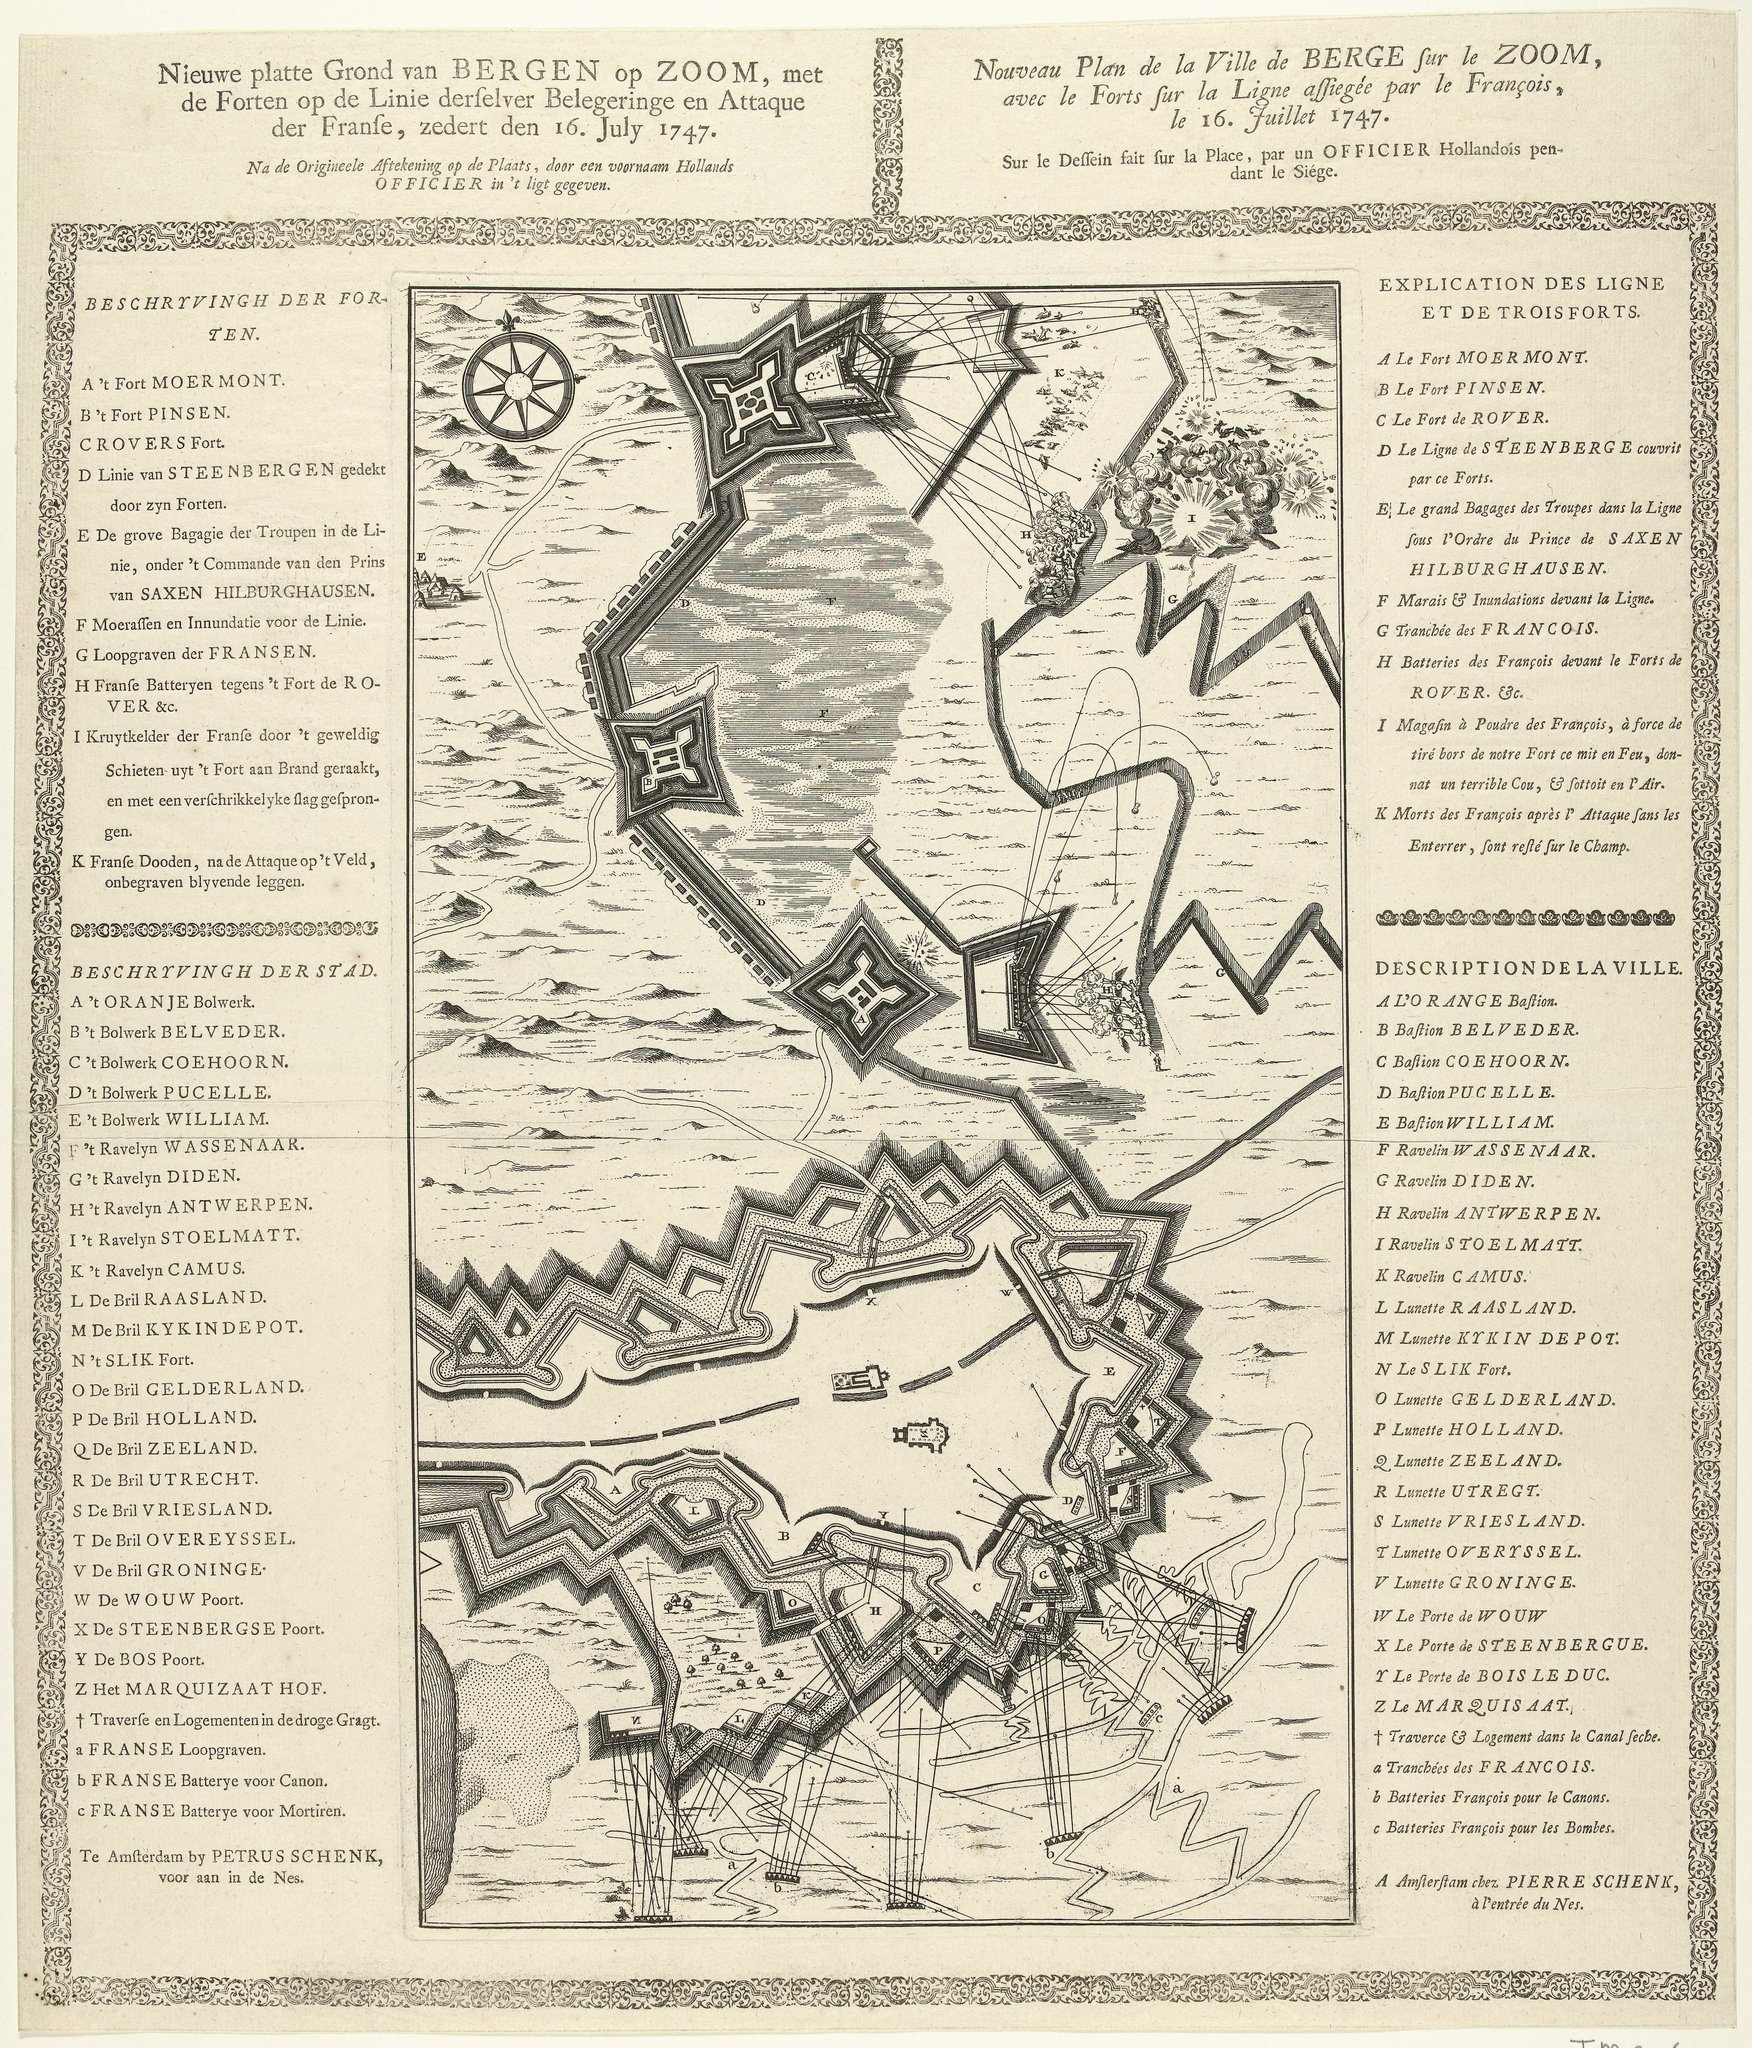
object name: print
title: Nieuwe platte Grond van Bergen op Zoom, met de Forten op de Linie derselver Belegeringe en Attaque der Franse, zedert den 16. July 1747 / Nouveau Plan de la Ville de Berge sur le Zoom (...)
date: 1747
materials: paper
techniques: etching, letterpress printing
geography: amsterdam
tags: maps of separate countries or regions, siege, position war, bergen op zoom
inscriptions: collector's mark: Lugt 2228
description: Plattegrond van het beleg van Bergen op Zoom door de Fransen, aangevangen op 12 juli 1747. Kaart gedrukt van één plaat met aan weerszijden de legenda's in het Nederlands en Frans, het geheel in een decoratieve rand.